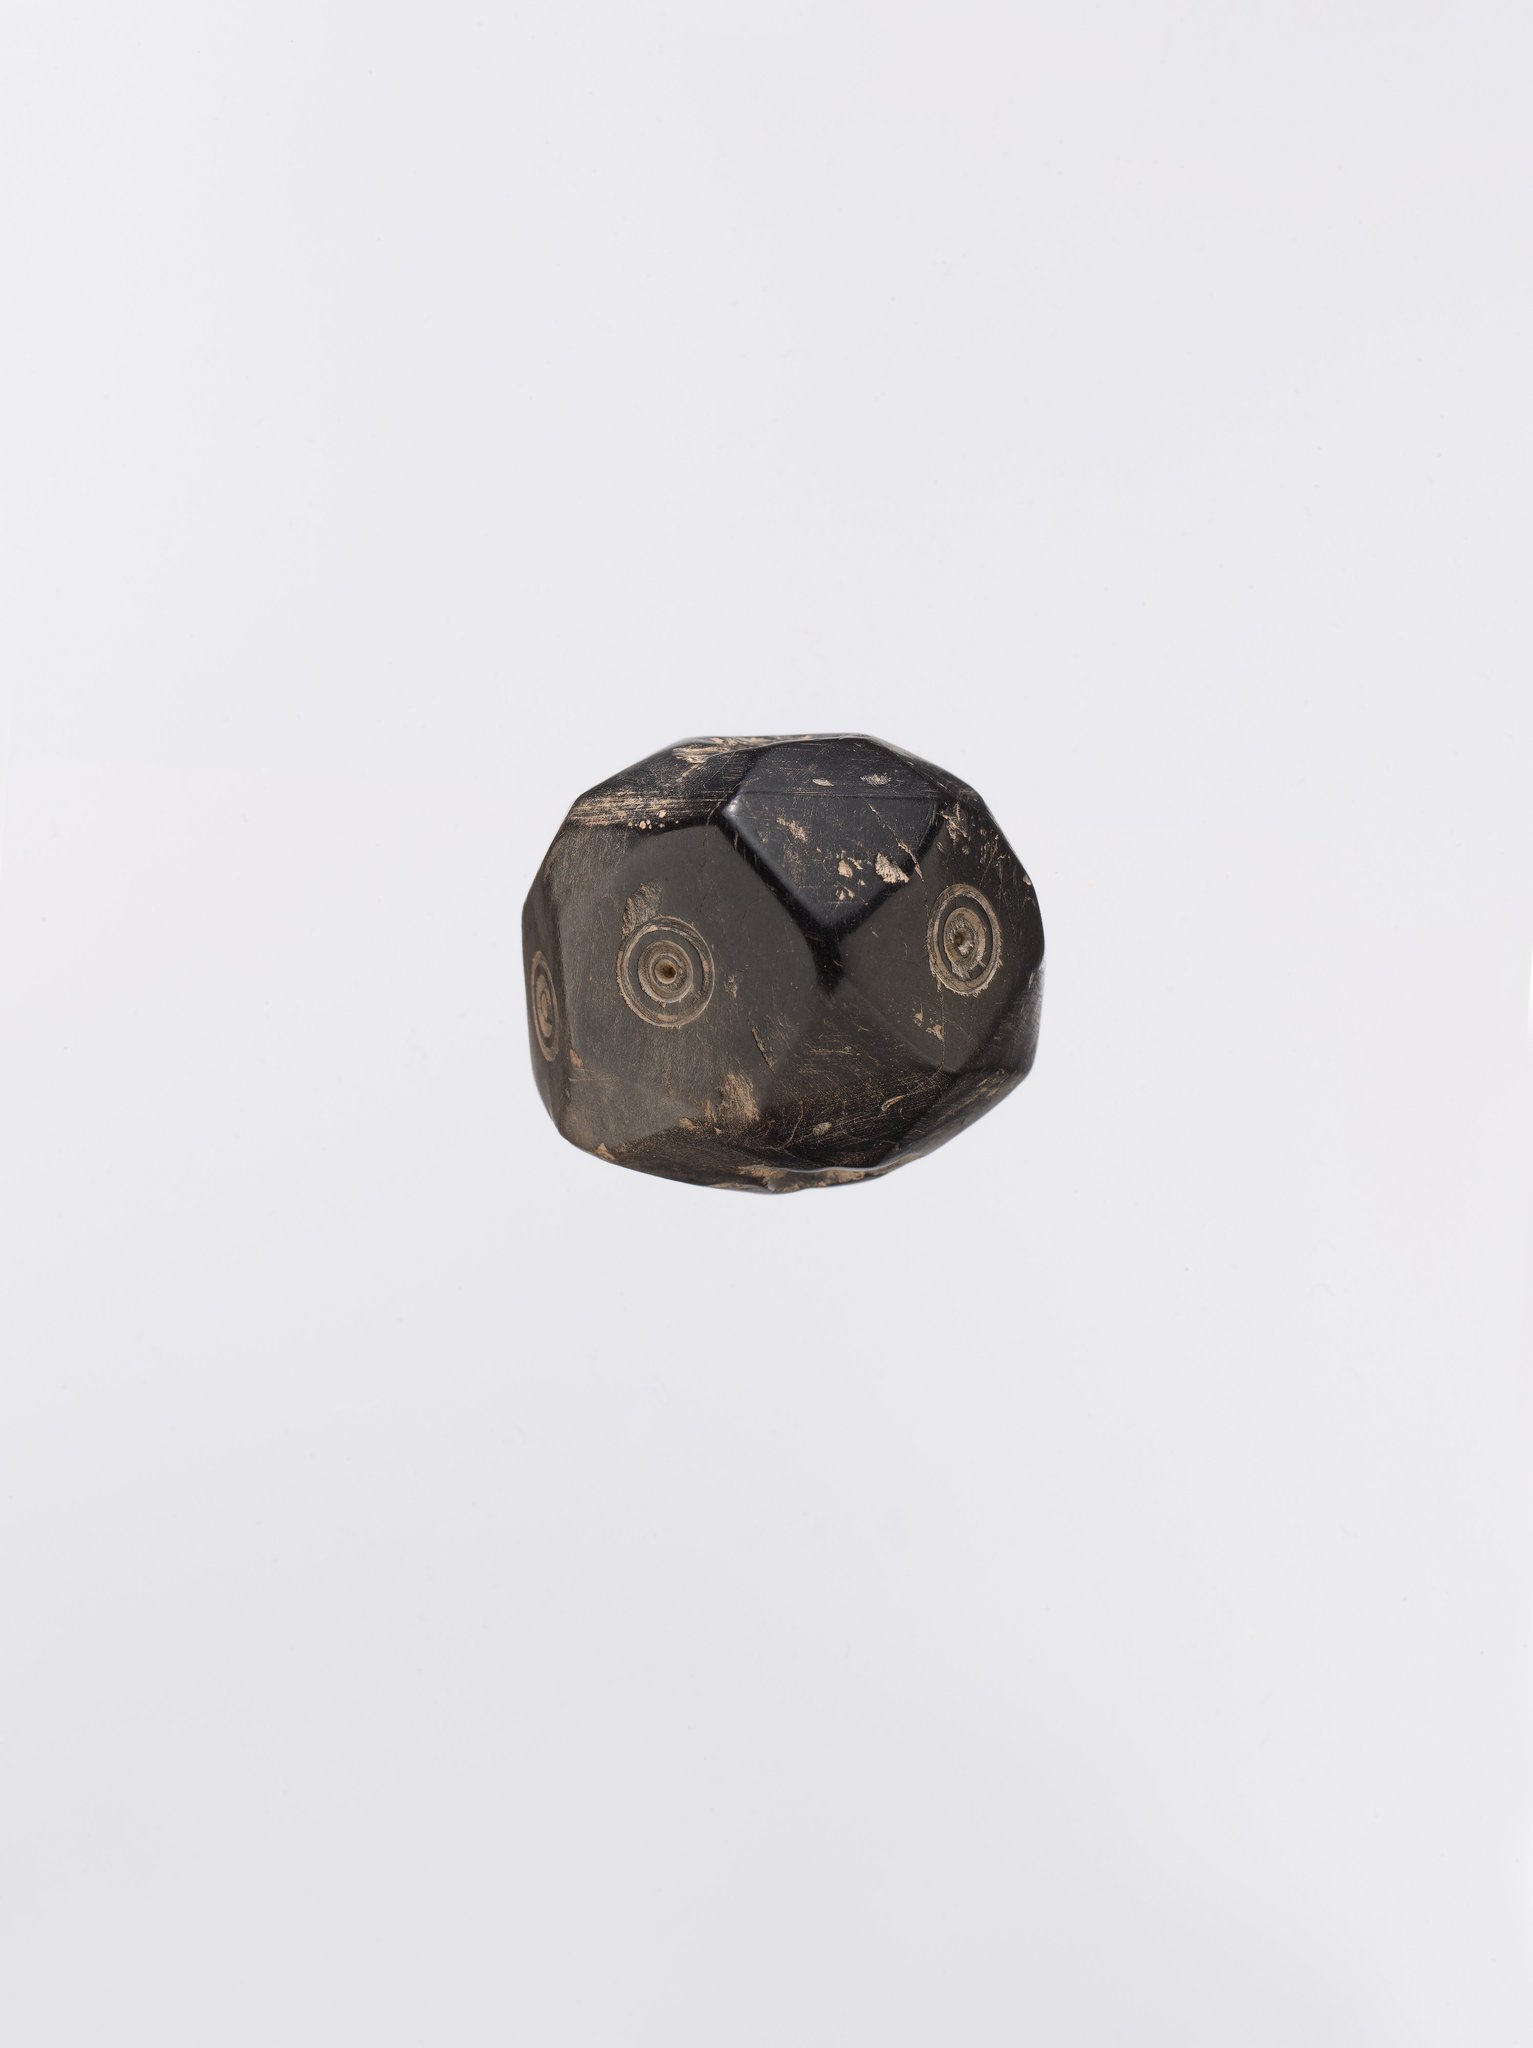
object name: bead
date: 801-1000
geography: iran